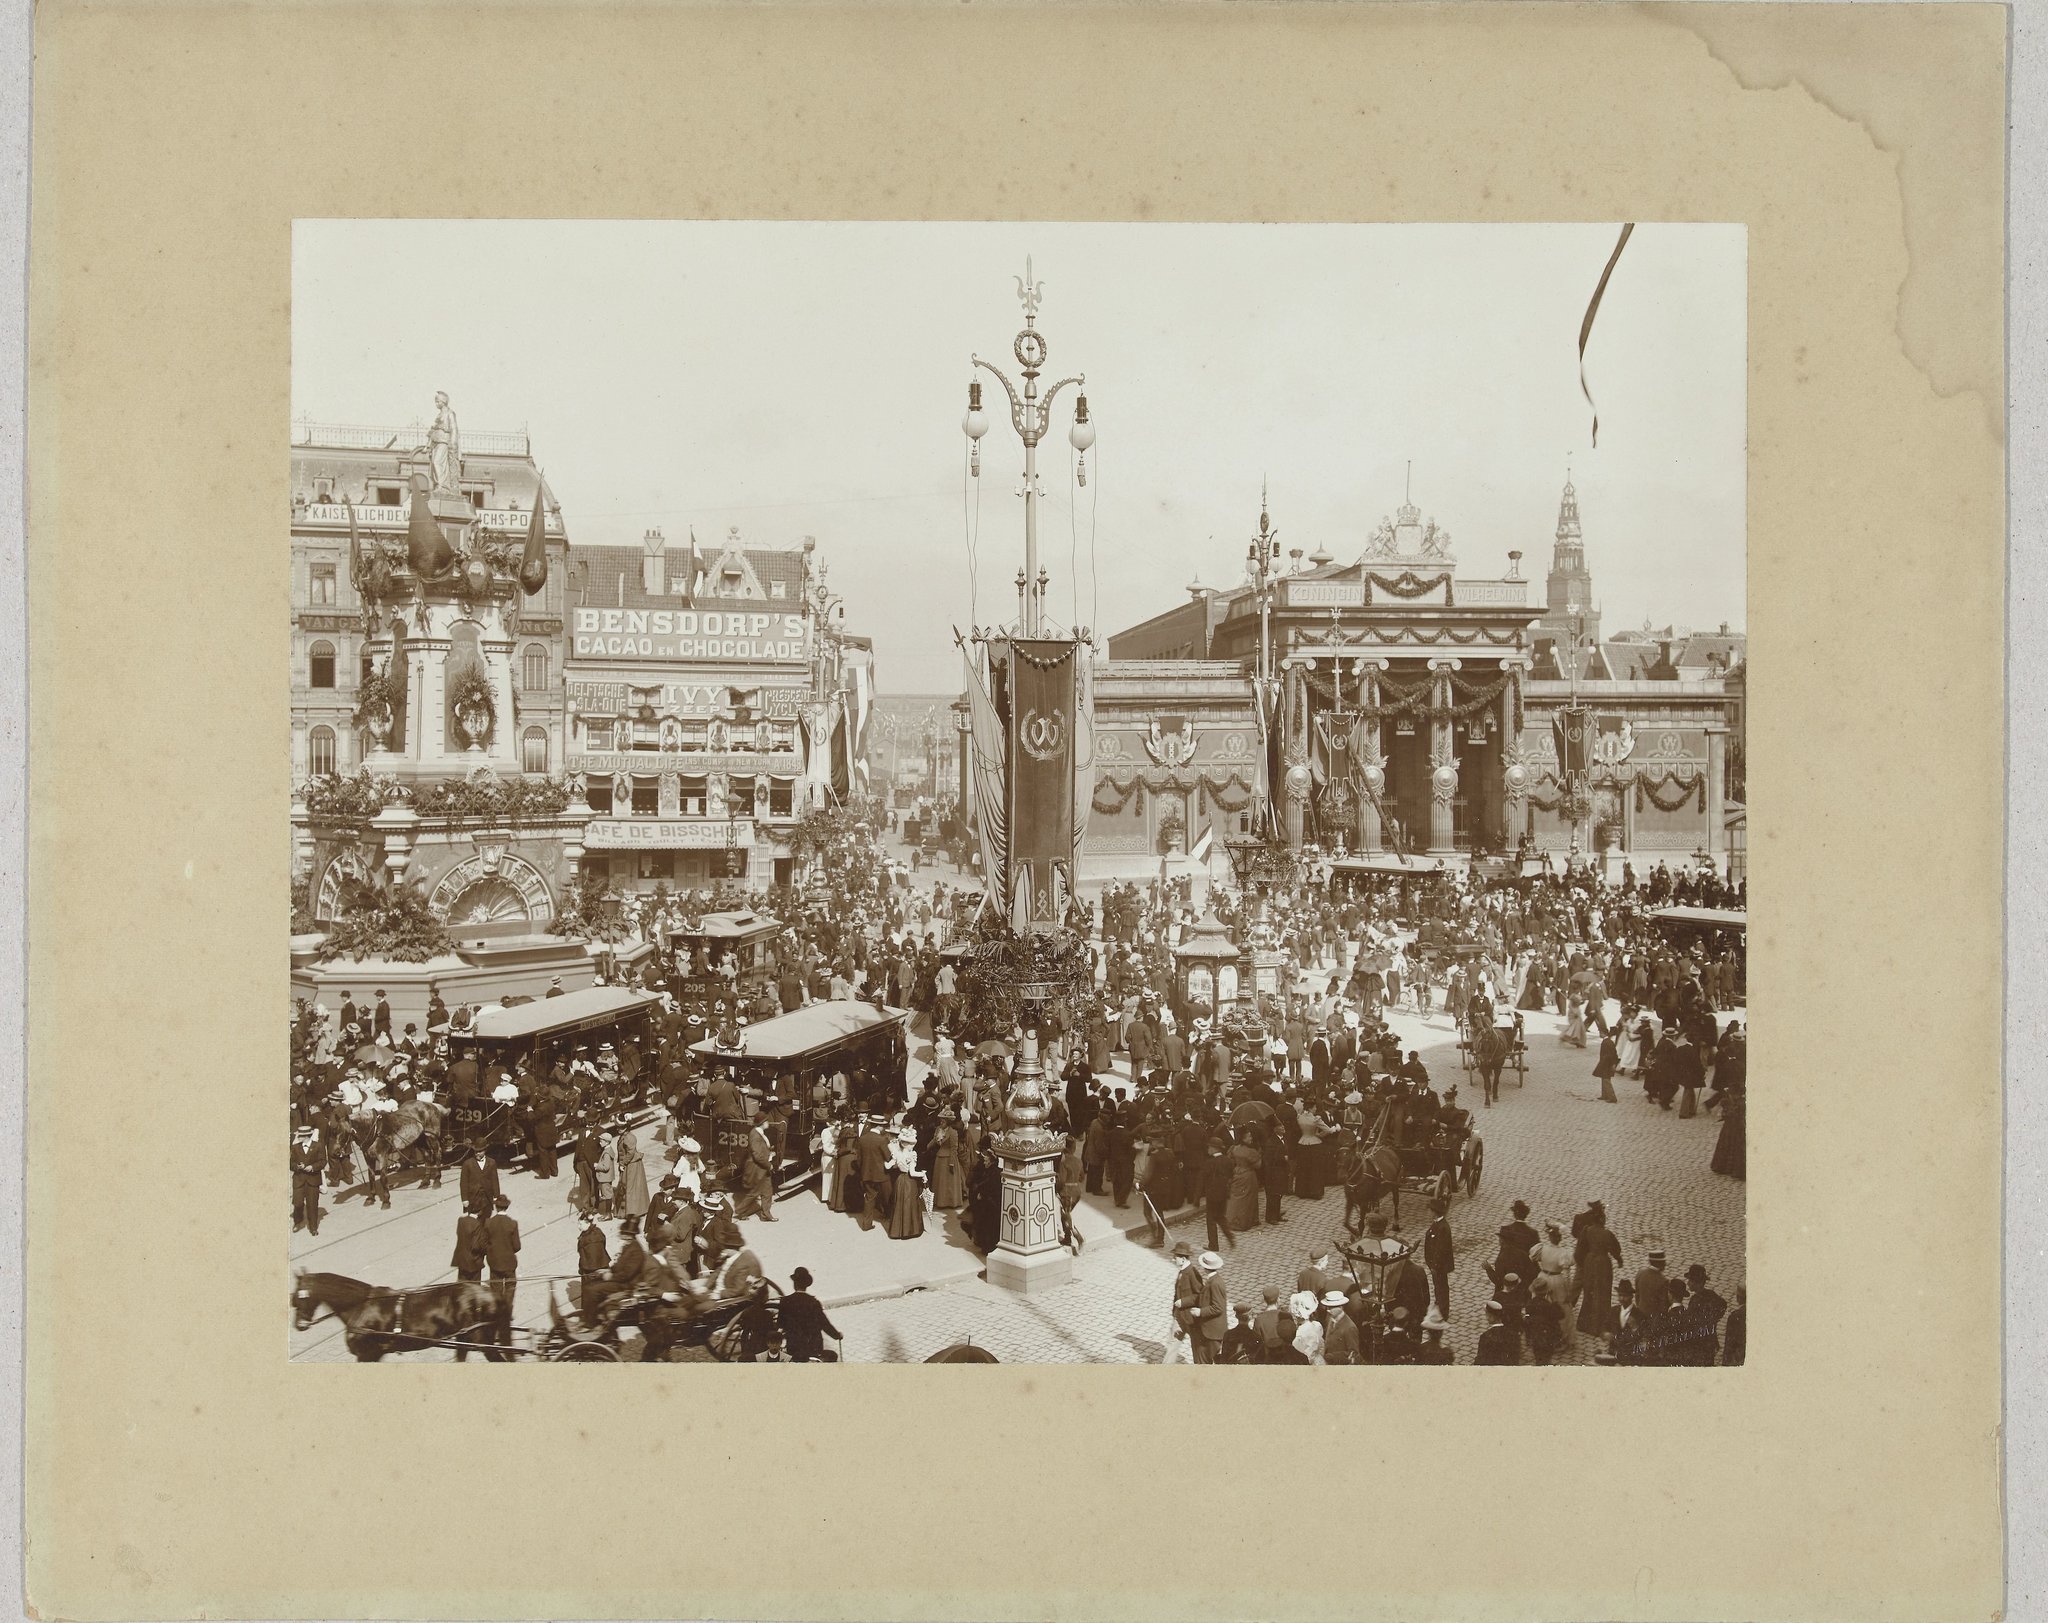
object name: photograph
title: Decoraties op de Dam, Amsterdam, tijdens de inhuldiging van Wilhelmina als koningin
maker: sigmund löw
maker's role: publisher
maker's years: 1845-1920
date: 1809-1898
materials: paper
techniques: collodion silver print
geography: amsterdam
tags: the hague, print maker, wilhelmina of the netherlands, square, place, circus, etc., festivities, amsterdam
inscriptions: title: ‘No. 9, 5 tot 9 september 1898. Versiering van het Damplein te Amsterdam gedurende de Inhuldigingsfeesten. Uitgave HERZ Amsterdam’, name: ‘atelier Herz Amsterdam’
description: Links is het monument Eendracht zichtbaar, rechts de beurs van Zocher